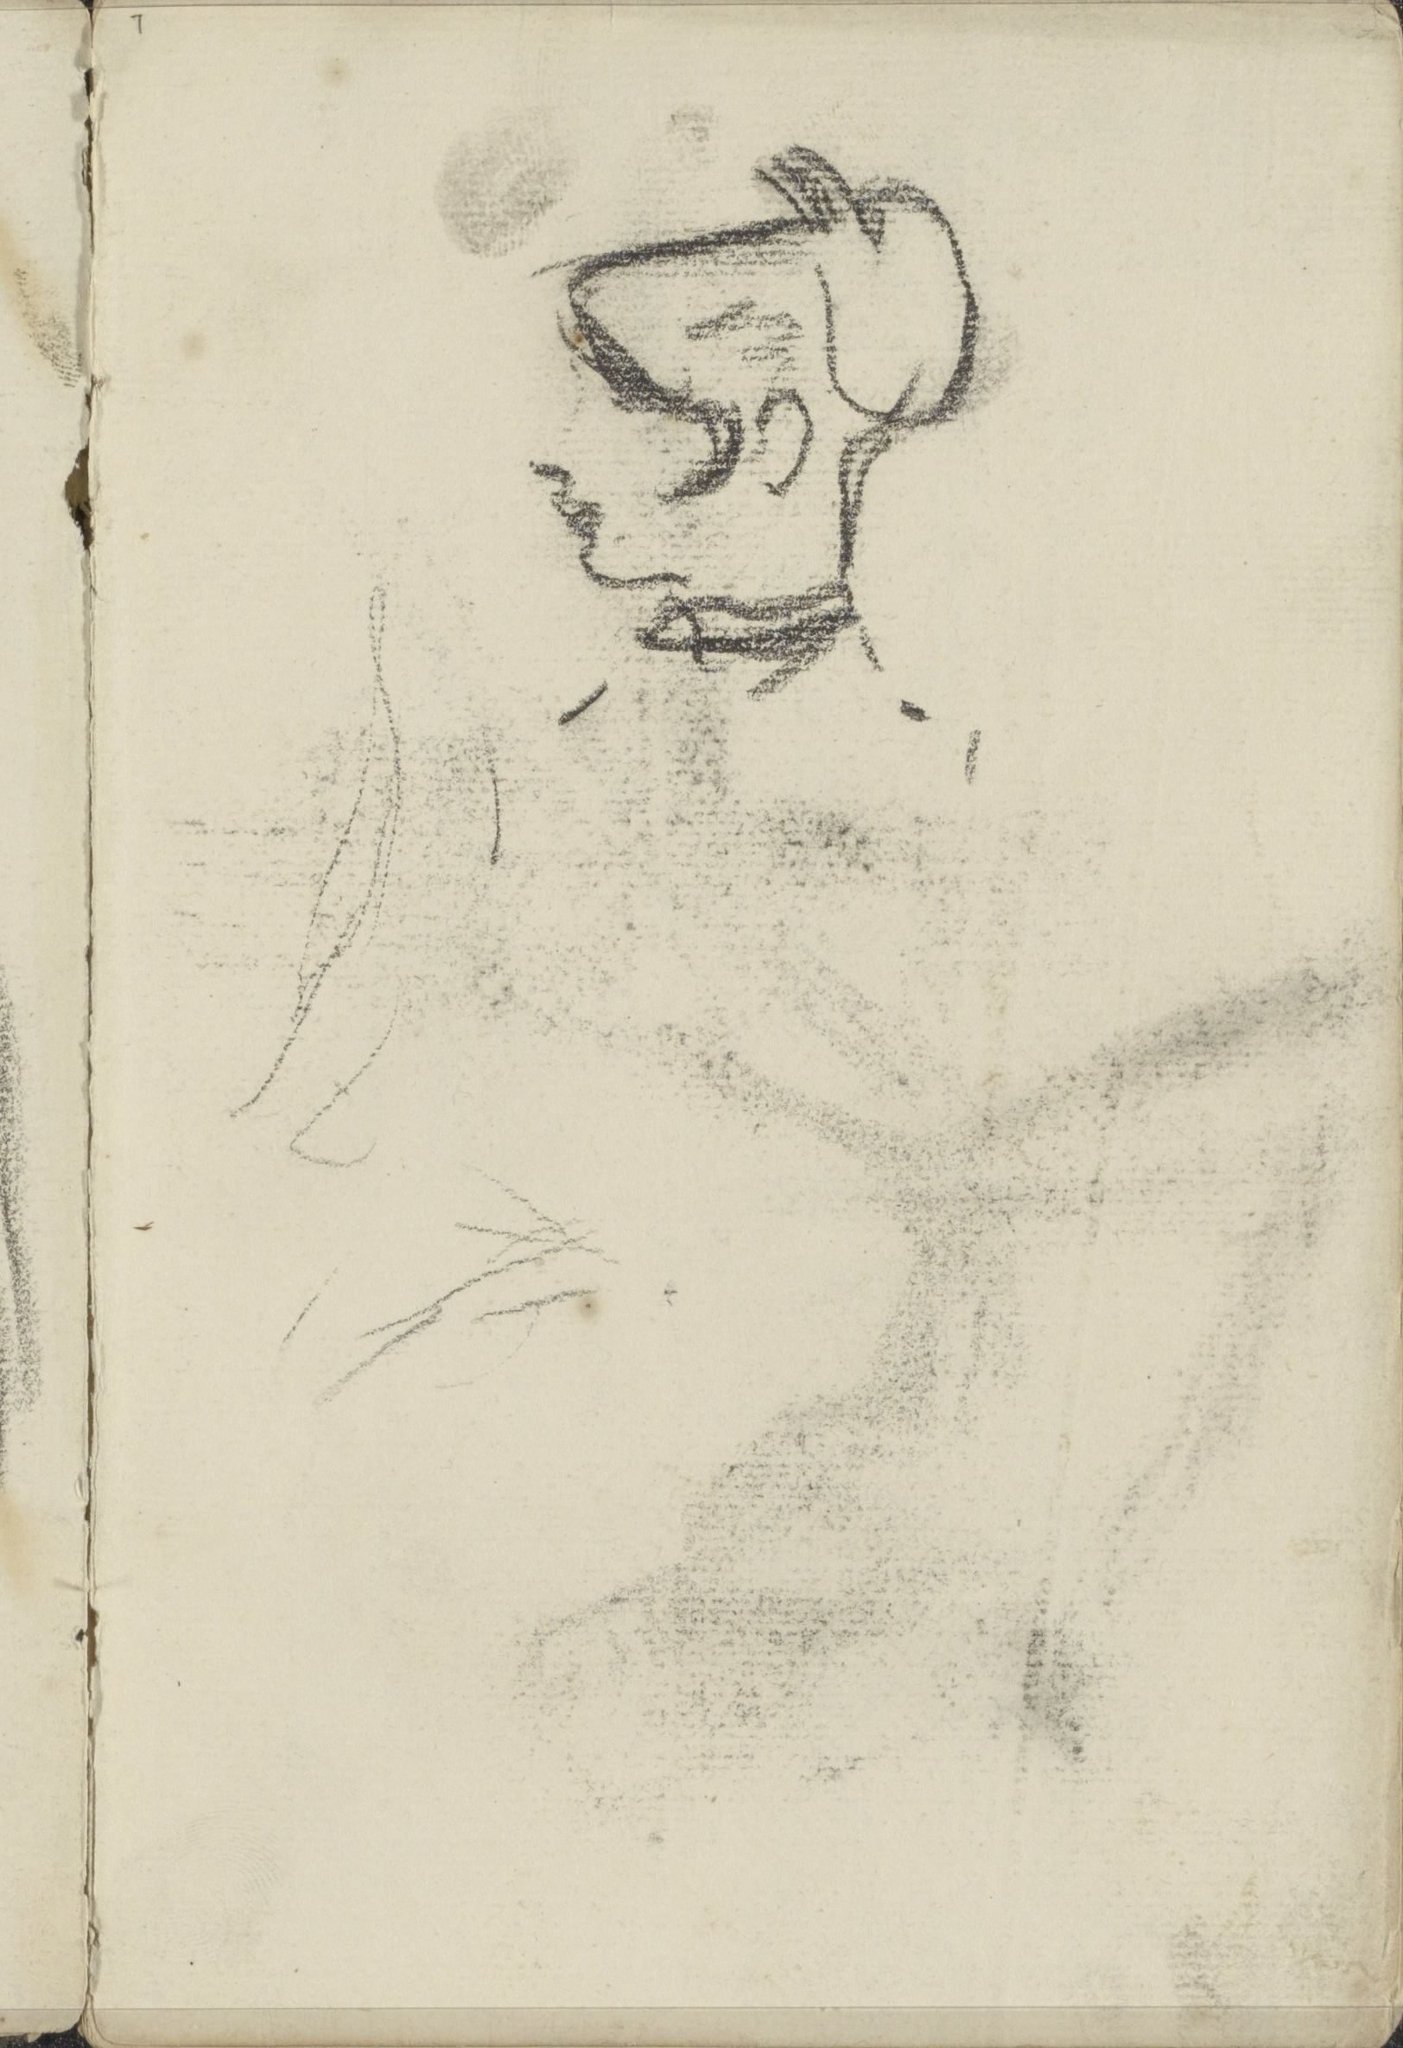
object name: sketchbook leaf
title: Vrouwenhoofd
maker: george hendrik breitner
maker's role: draughtsman, painter, print maker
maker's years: 1857-1923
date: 1886-1923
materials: chalk, paper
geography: amsterdam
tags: head (human) - aa - female human figure (+ sideview, profile)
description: Pagina 6 uit een schetsboek met 13 bladen.